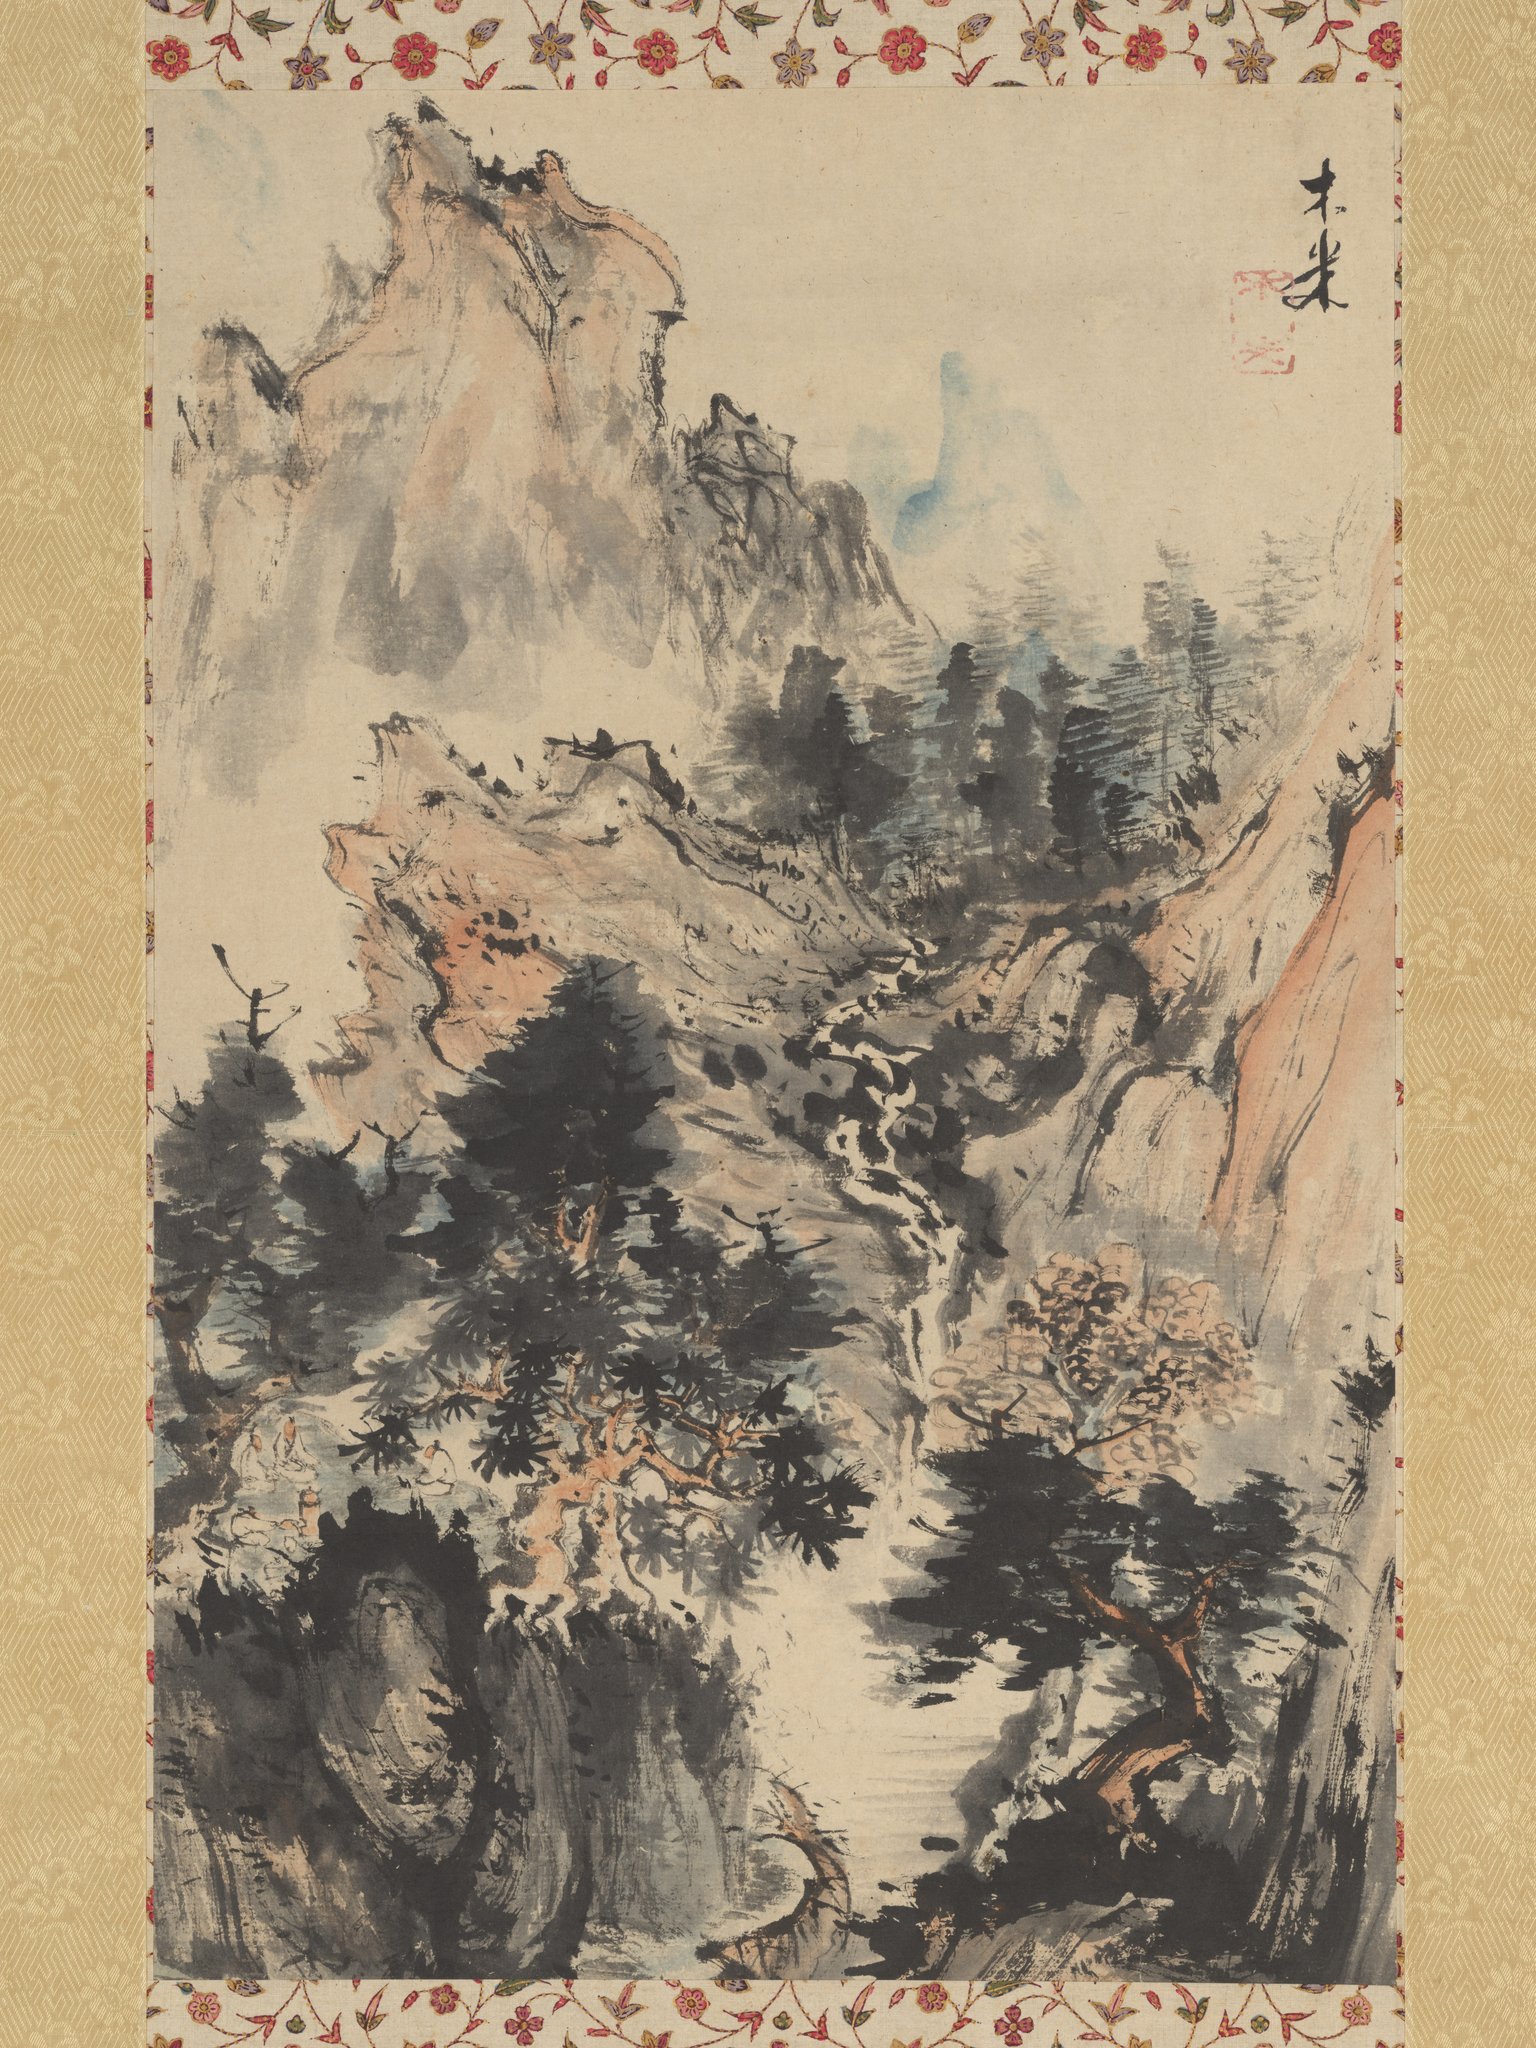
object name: hanging scroll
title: Brewing Tea in the Shade of Trees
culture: japanese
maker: aoki mokubei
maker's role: artist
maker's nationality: japanese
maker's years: 1767-1833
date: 1820-1829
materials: ink, paper